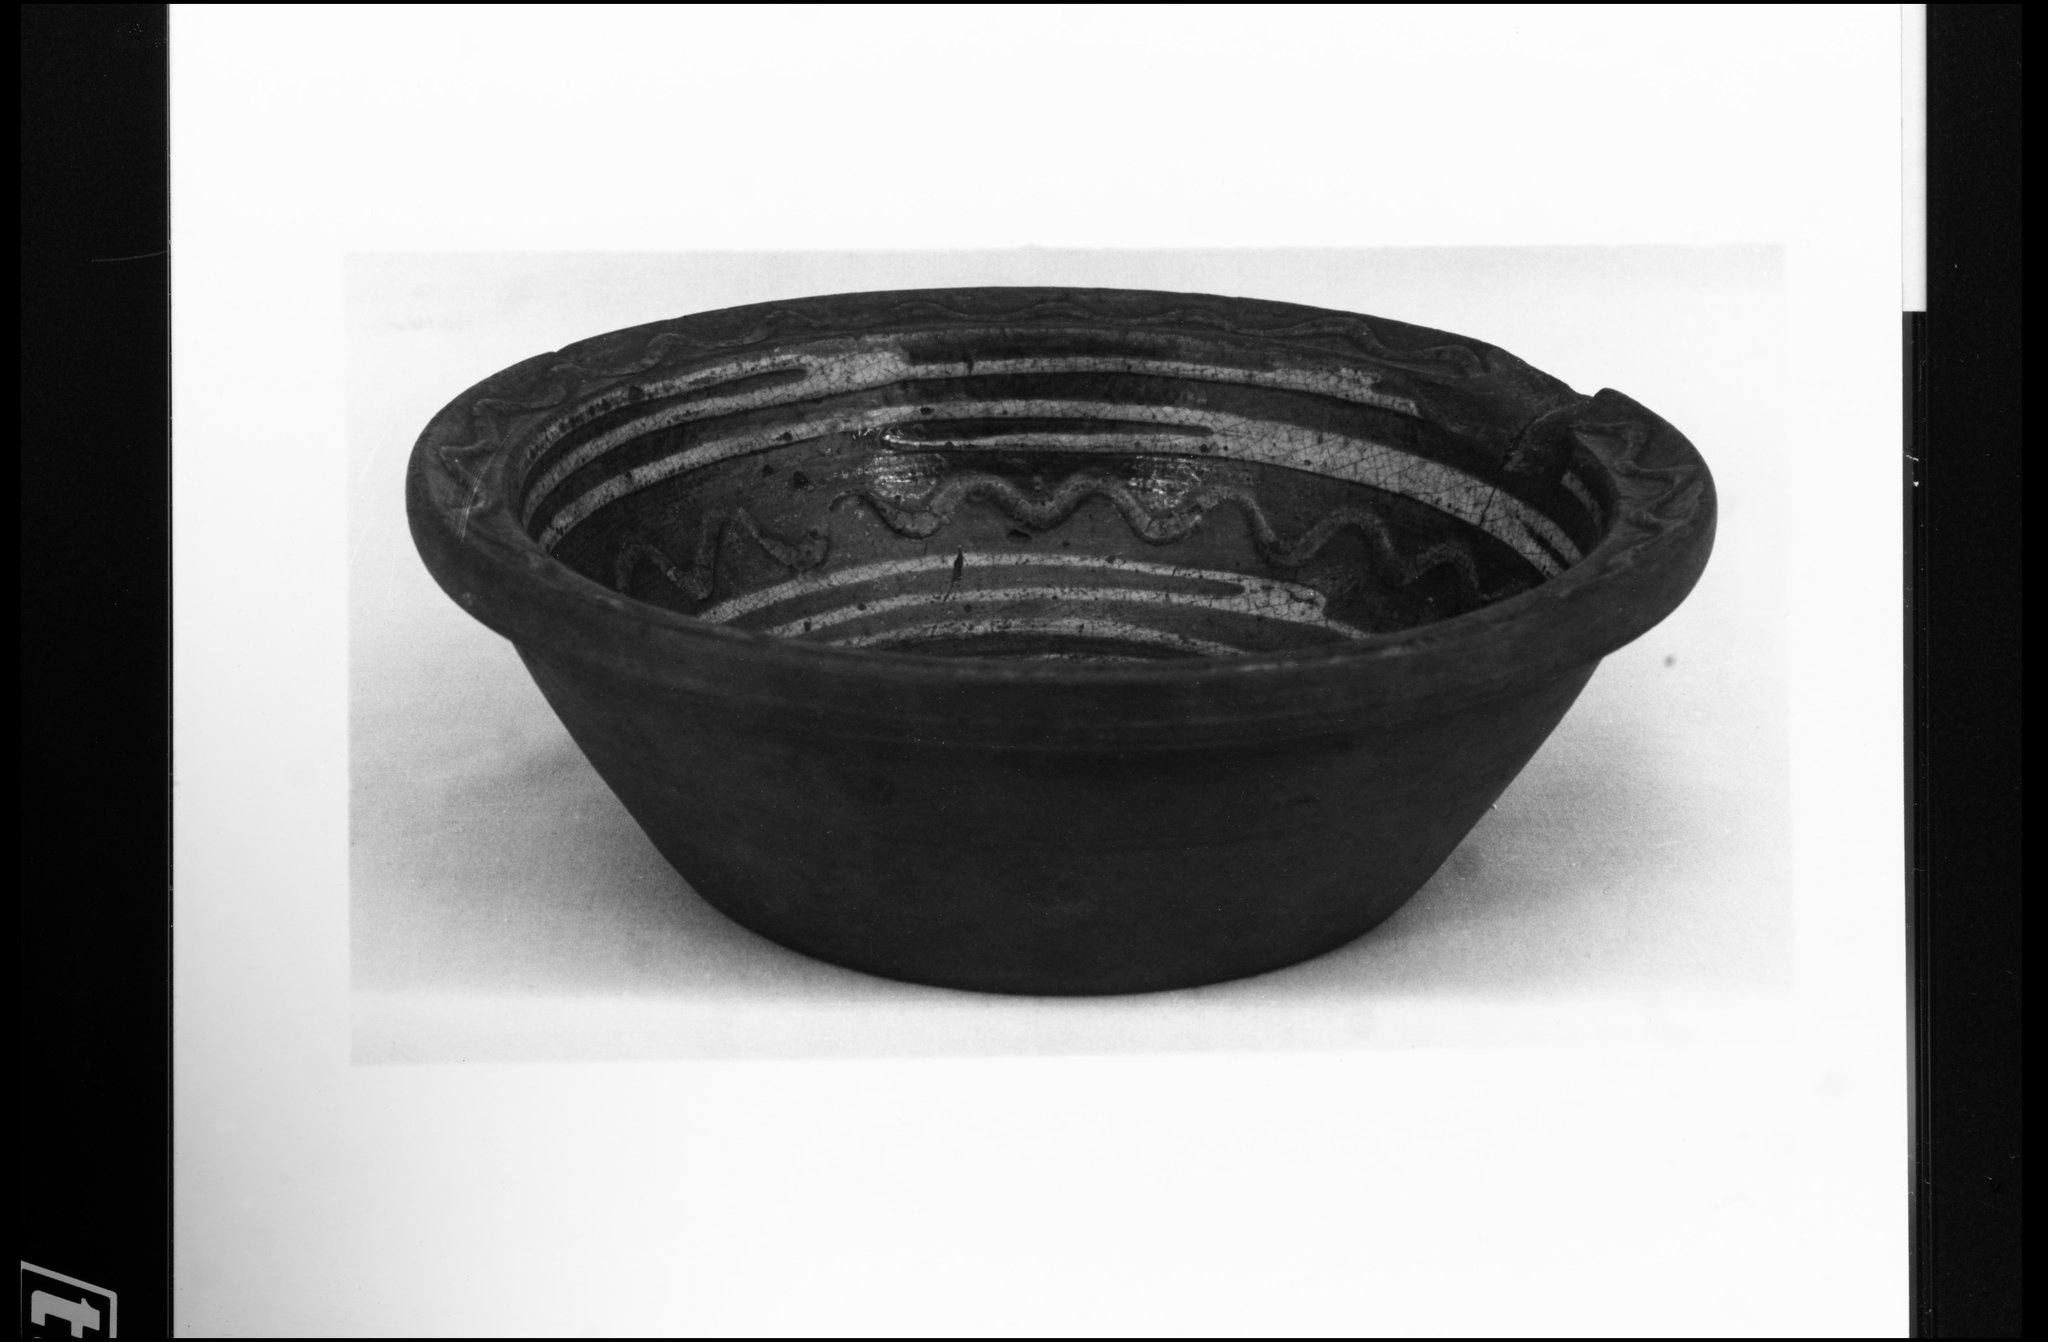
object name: bowl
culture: american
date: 1800-1814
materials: earthenware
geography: united states